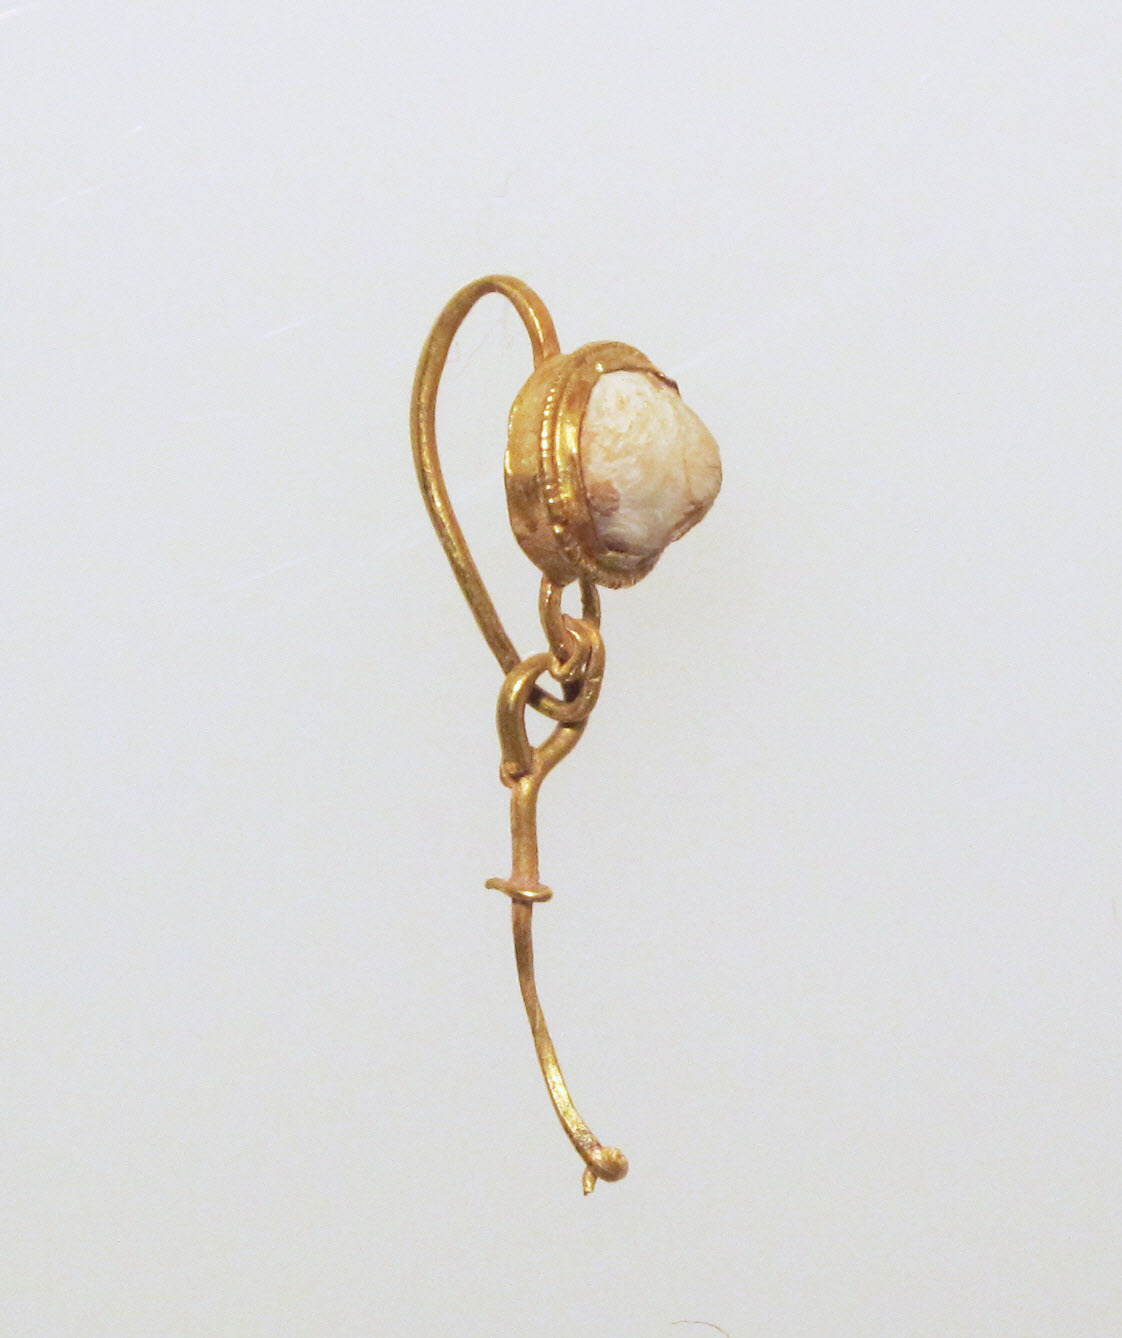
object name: earring with pendant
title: Gold earring with pearl setting and pendant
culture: roman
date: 670 BCE-330 CE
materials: gold